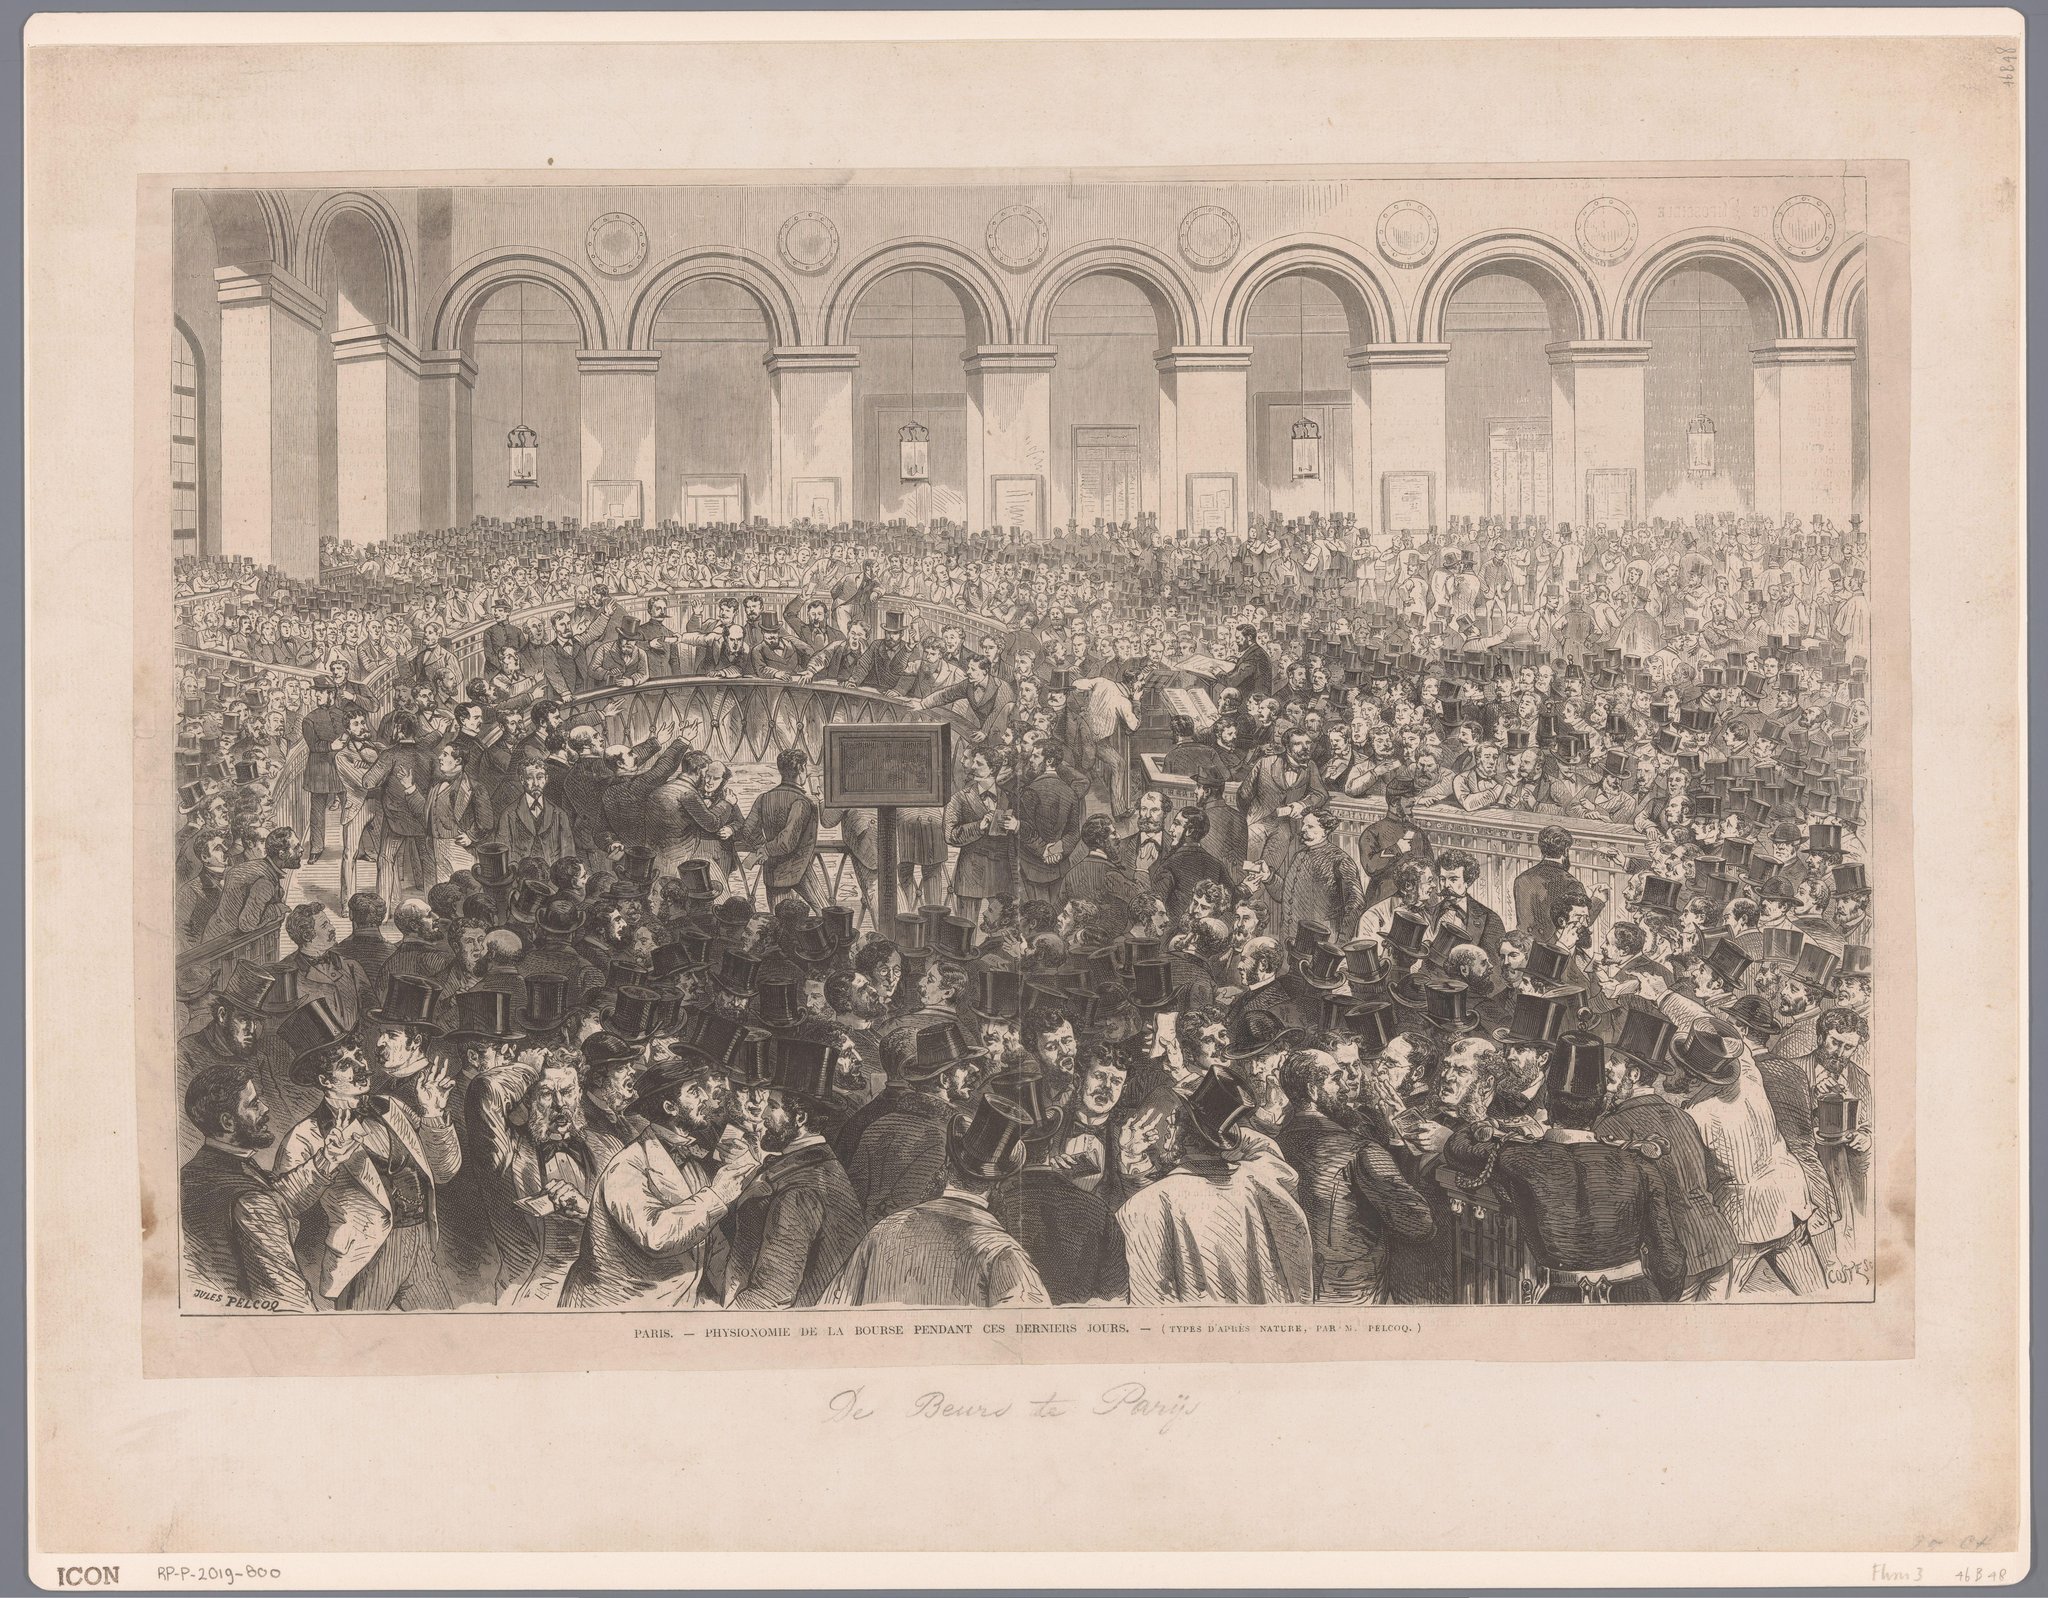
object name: print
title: Beurs te Parijs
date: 1744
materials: paper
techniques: letterpress printing, engraving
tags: exchange, bourse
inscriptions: collector's mark: Lugt 2228